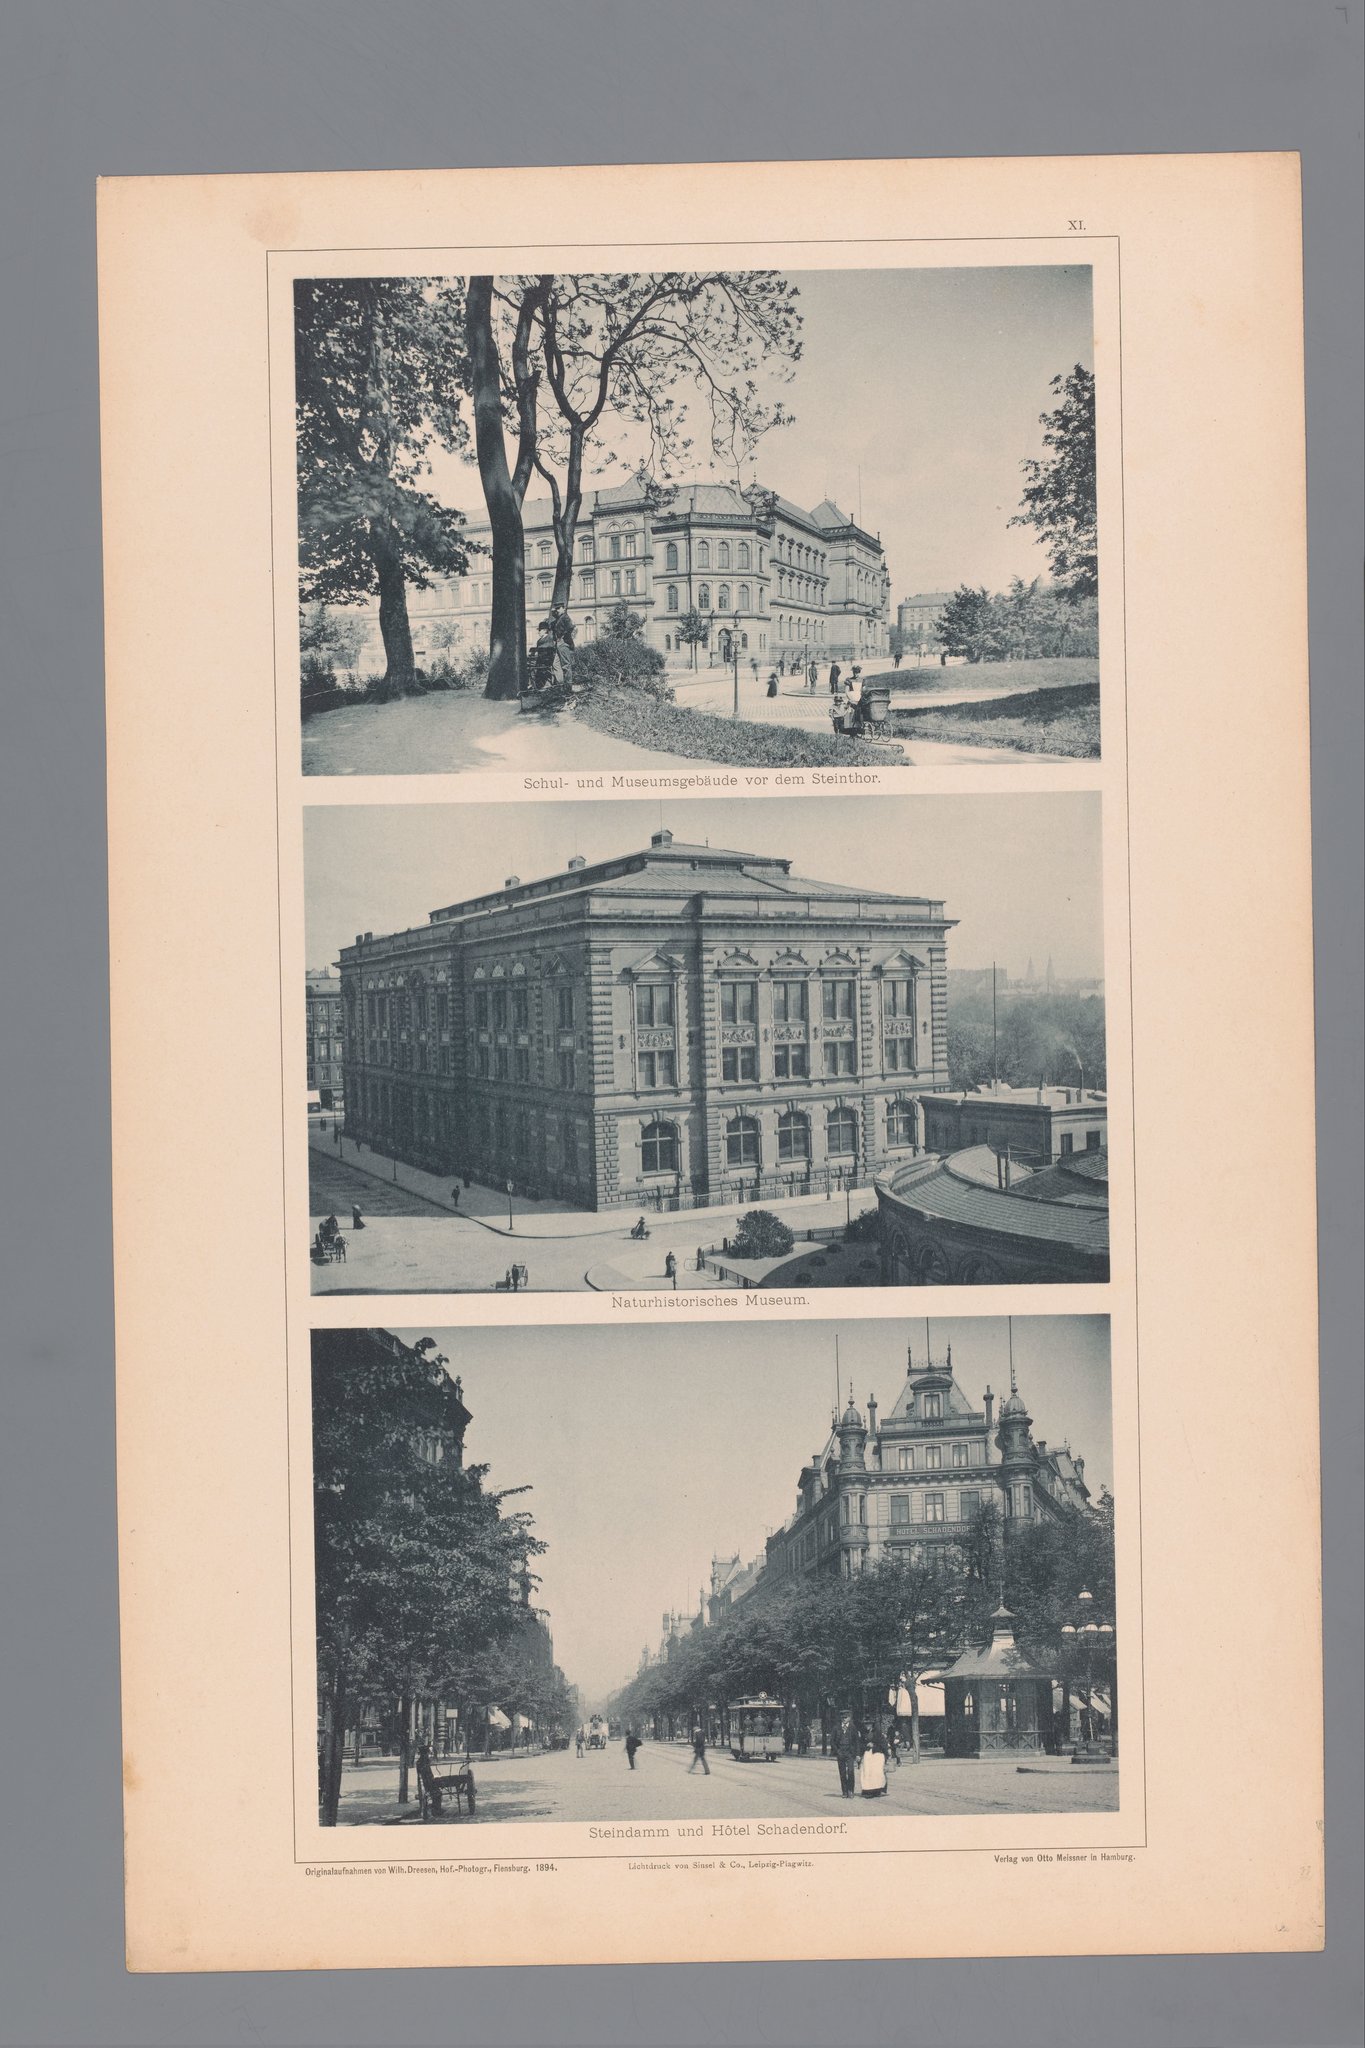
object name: photomechanical print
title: Schul- und Museumsgebäude vor dem Steinthor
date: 1894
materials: paper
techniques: photograph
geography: hamburg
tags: permanent exhibition, museum, street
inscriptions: inscription: ‘Originalaufnahmen von Wilh. Dreesen, Hof.-Photogr., Flensburg. 1894.’, number: ‘XI.’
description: Deze prenten maken deel uit van een omslag met 126 prenten op 37 bladen en een tekstblad.